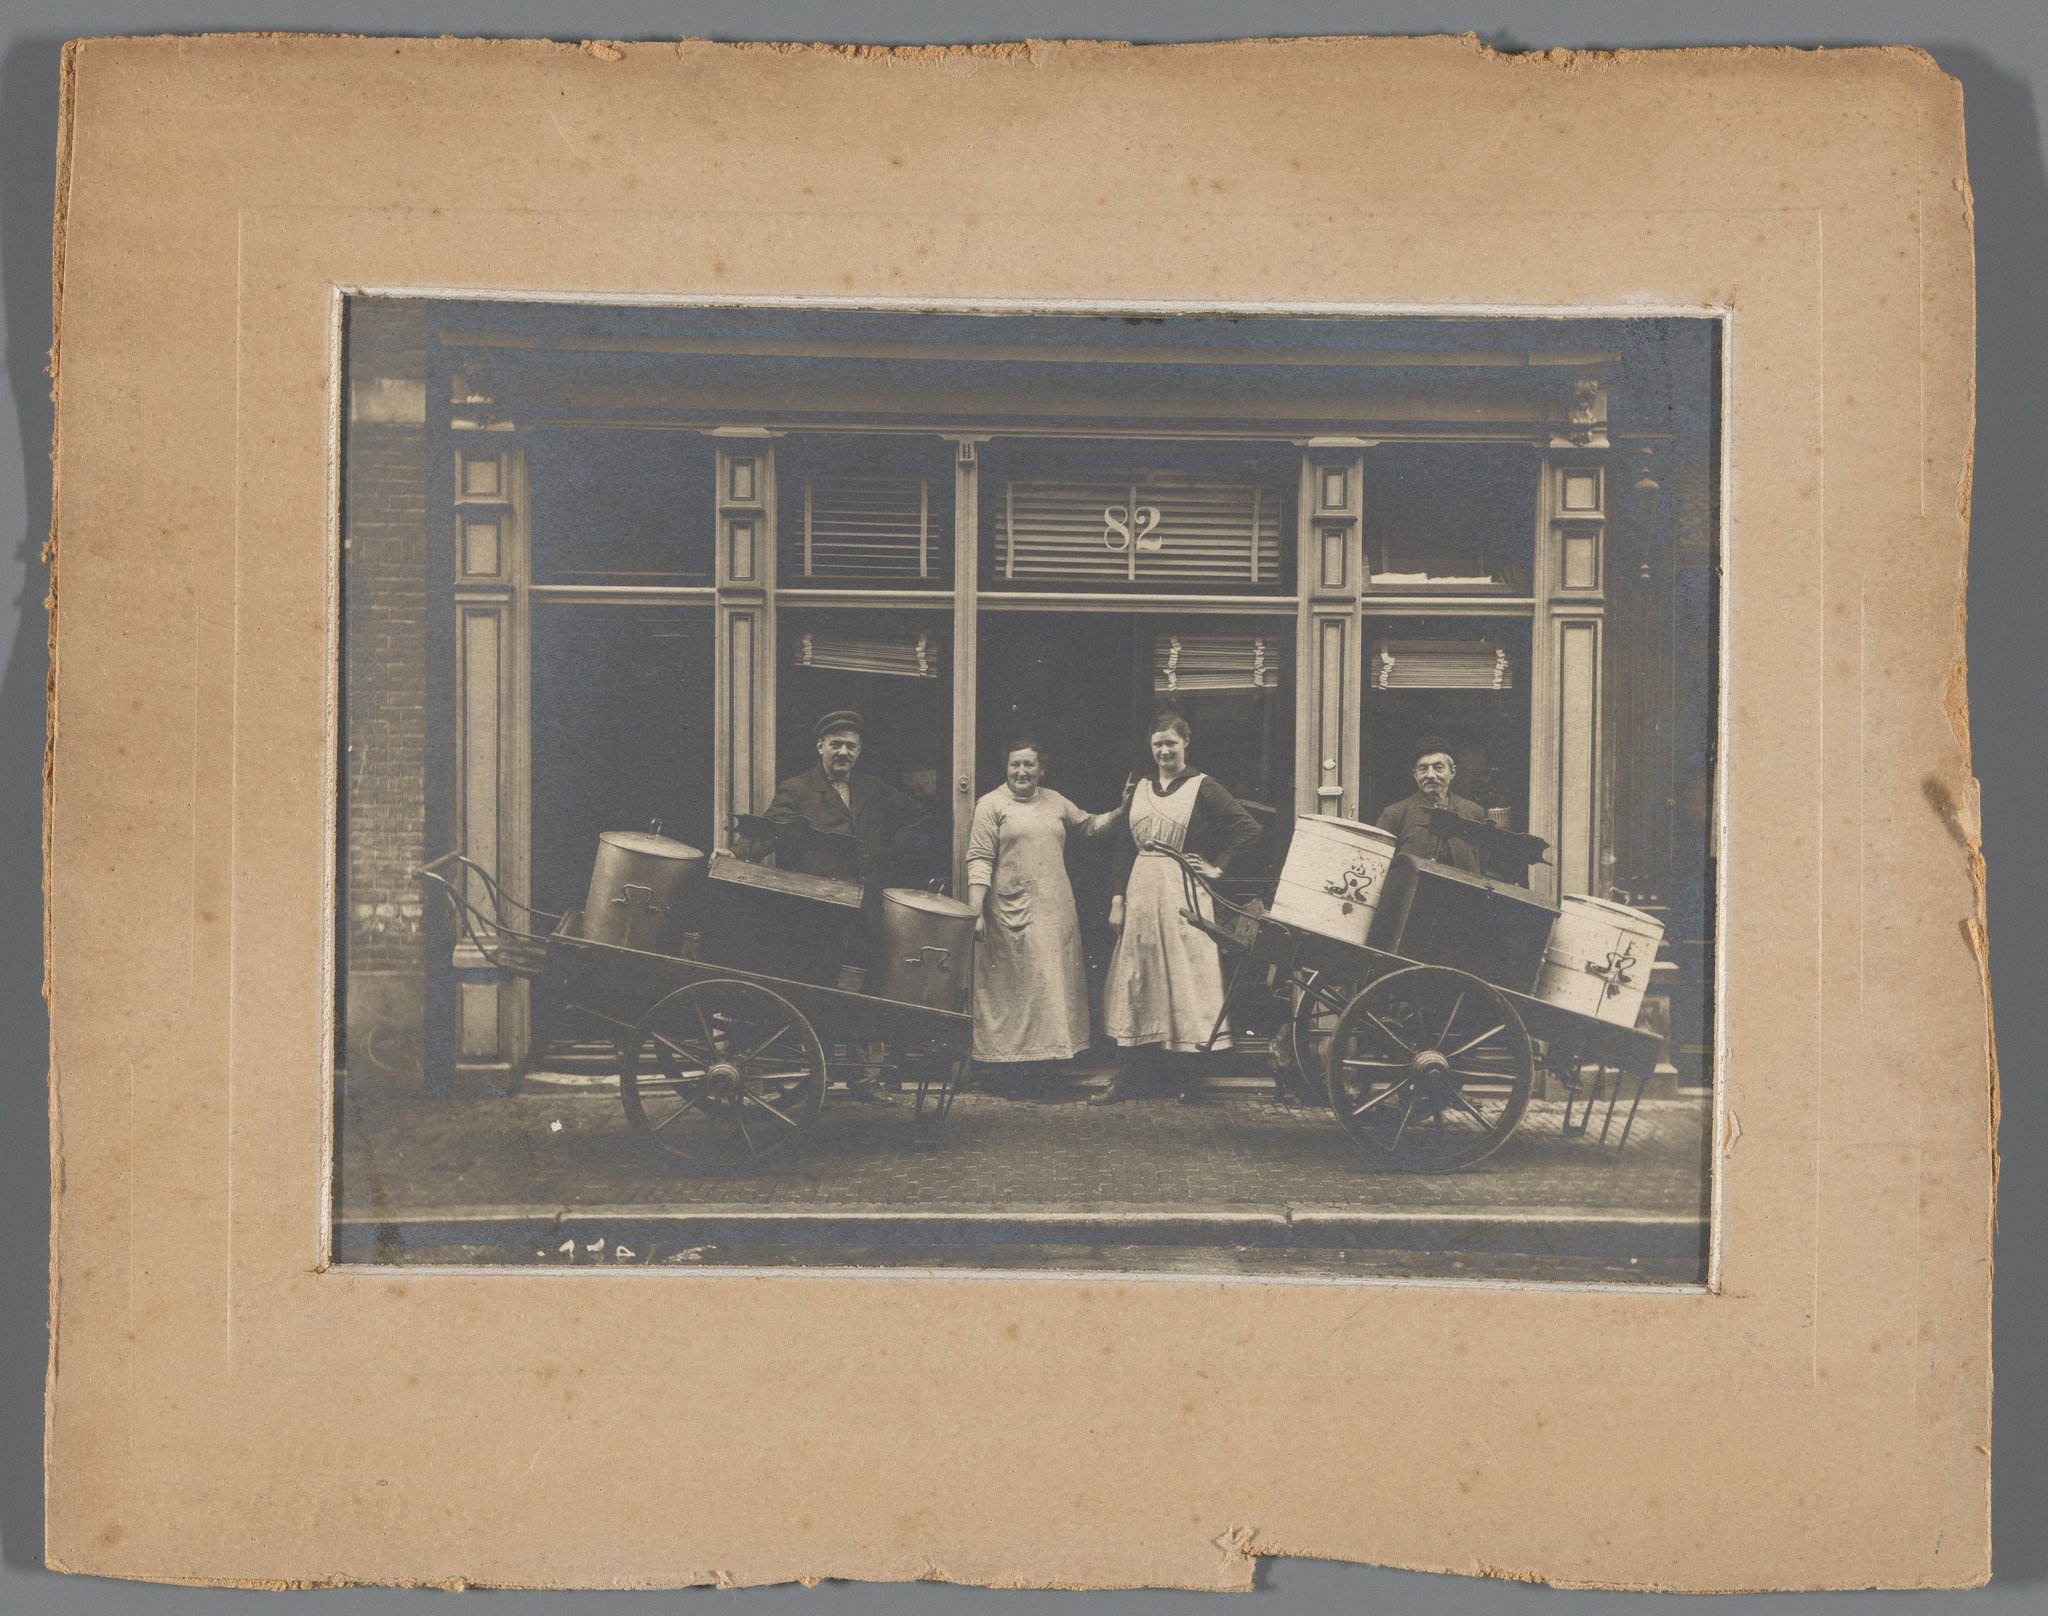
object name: photograph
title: Twee mannen en vrouwen met melkkarren voor een etalage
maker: Anonymous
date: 1910-1930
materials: paper, cardboard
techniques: gelatin silver print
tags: transportation of milk, shop-window, show-window